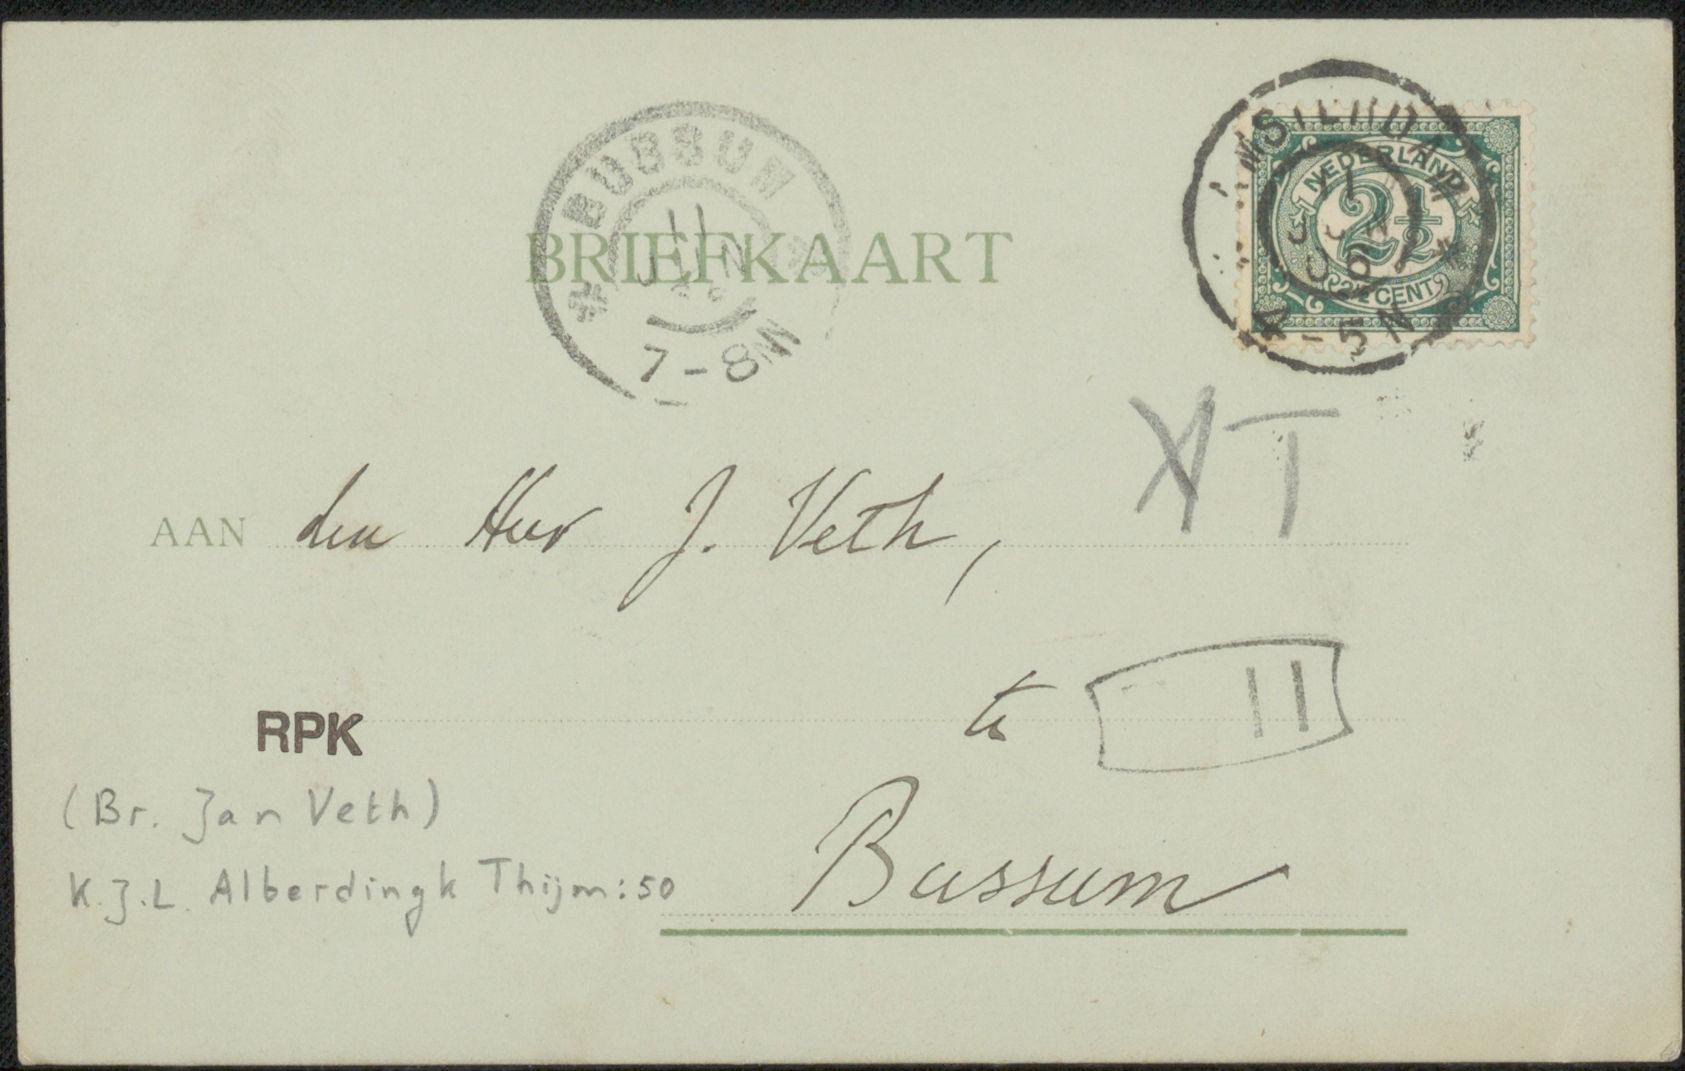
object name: postcard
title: Briefkaart aan Jan Veth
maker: karel johan lodewijk alberdingk thijm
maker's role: criticus, prozaschrijver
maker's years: 1864-1952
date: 1906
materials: cardboard, ink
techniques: pen, writing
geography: amsterdam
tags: designer, jan veth, leiden, painter, draughtsman, rembrandt van rijn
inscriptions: collector's mark: ‘RPK’